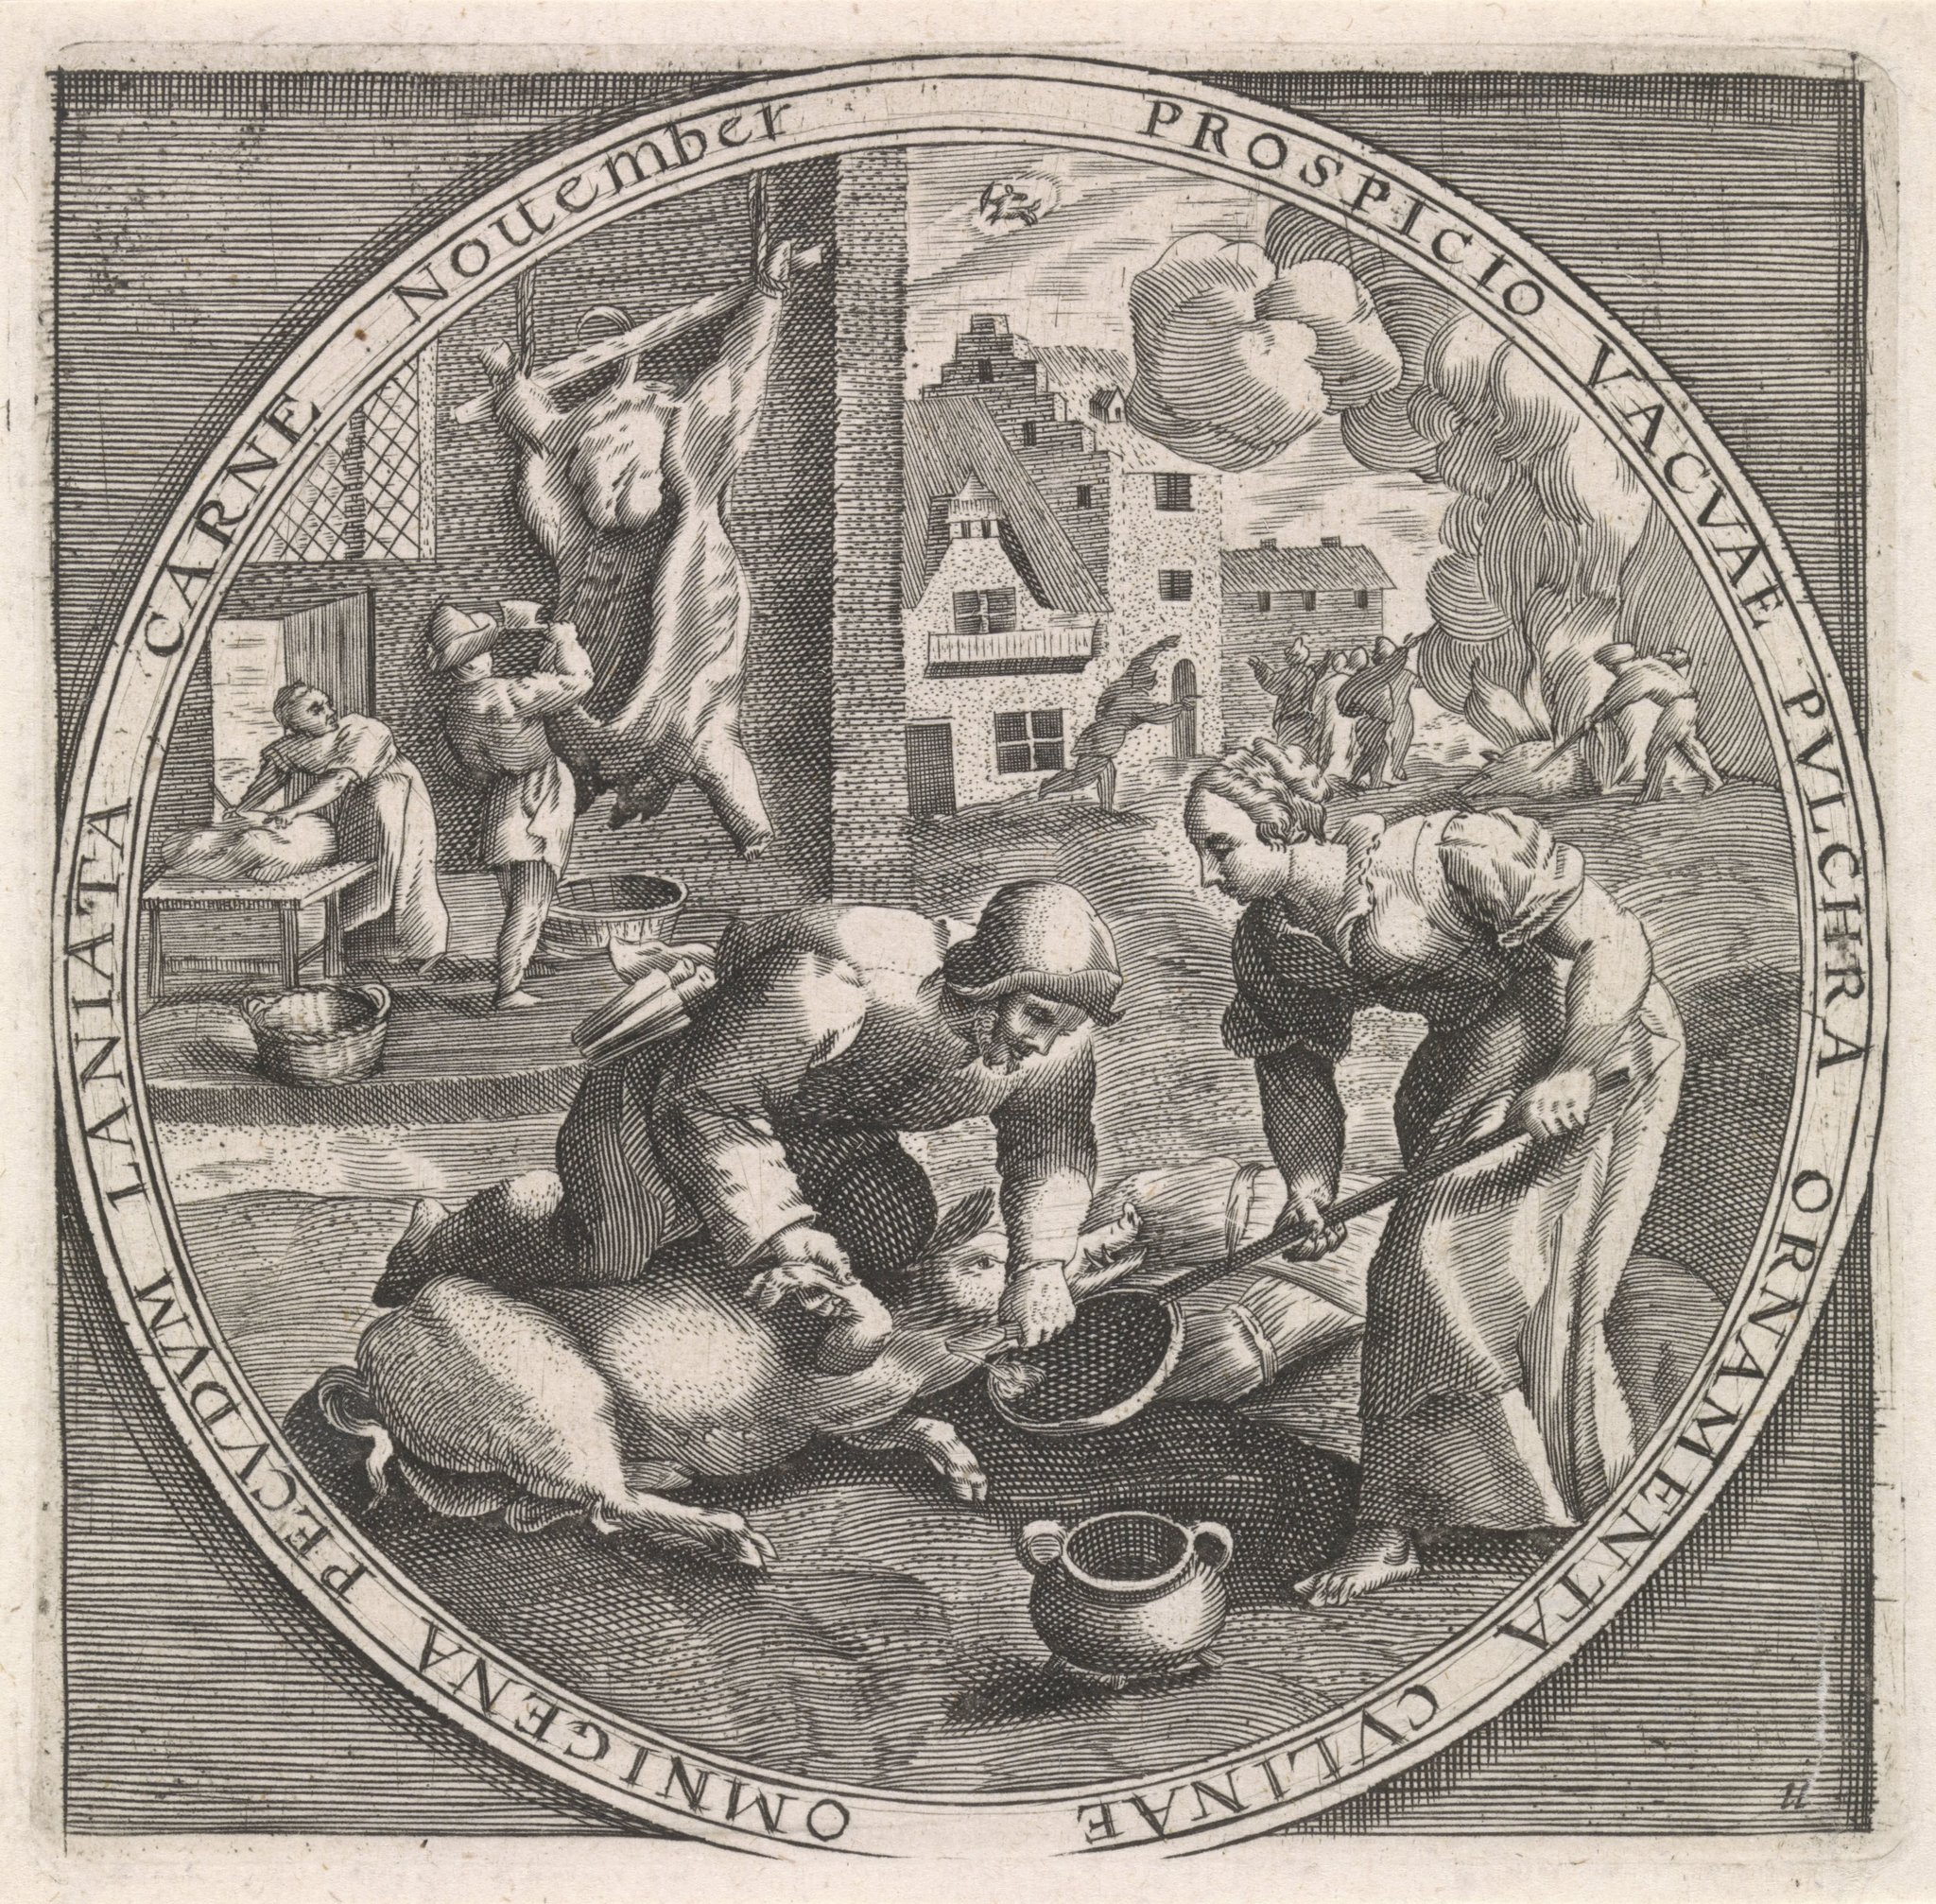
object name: print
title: De twaalf maanden van het jaar verbeeld in scènes uit het volksleven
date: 1574-1687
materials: paper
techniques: engraving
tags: slaughtered ox or pig, november and its 'labours' (+ with zodiacal signs)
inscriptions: collector's mark: Lugt 2228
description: De maand november: een man en vrouw die een varken slachten. Op de achtergrond een man die een varken uitbeent. Midden boven het teken van de dierenriem dat bij de maand november hoort: Boogschutter. De prent heeft een omlijsting met een randschrift in het Latijn dat verwijst naar de werken van de maand november. Kopie in spiegelbeeld naar de gelijknamige prent van Crispijn van de Passe (I).